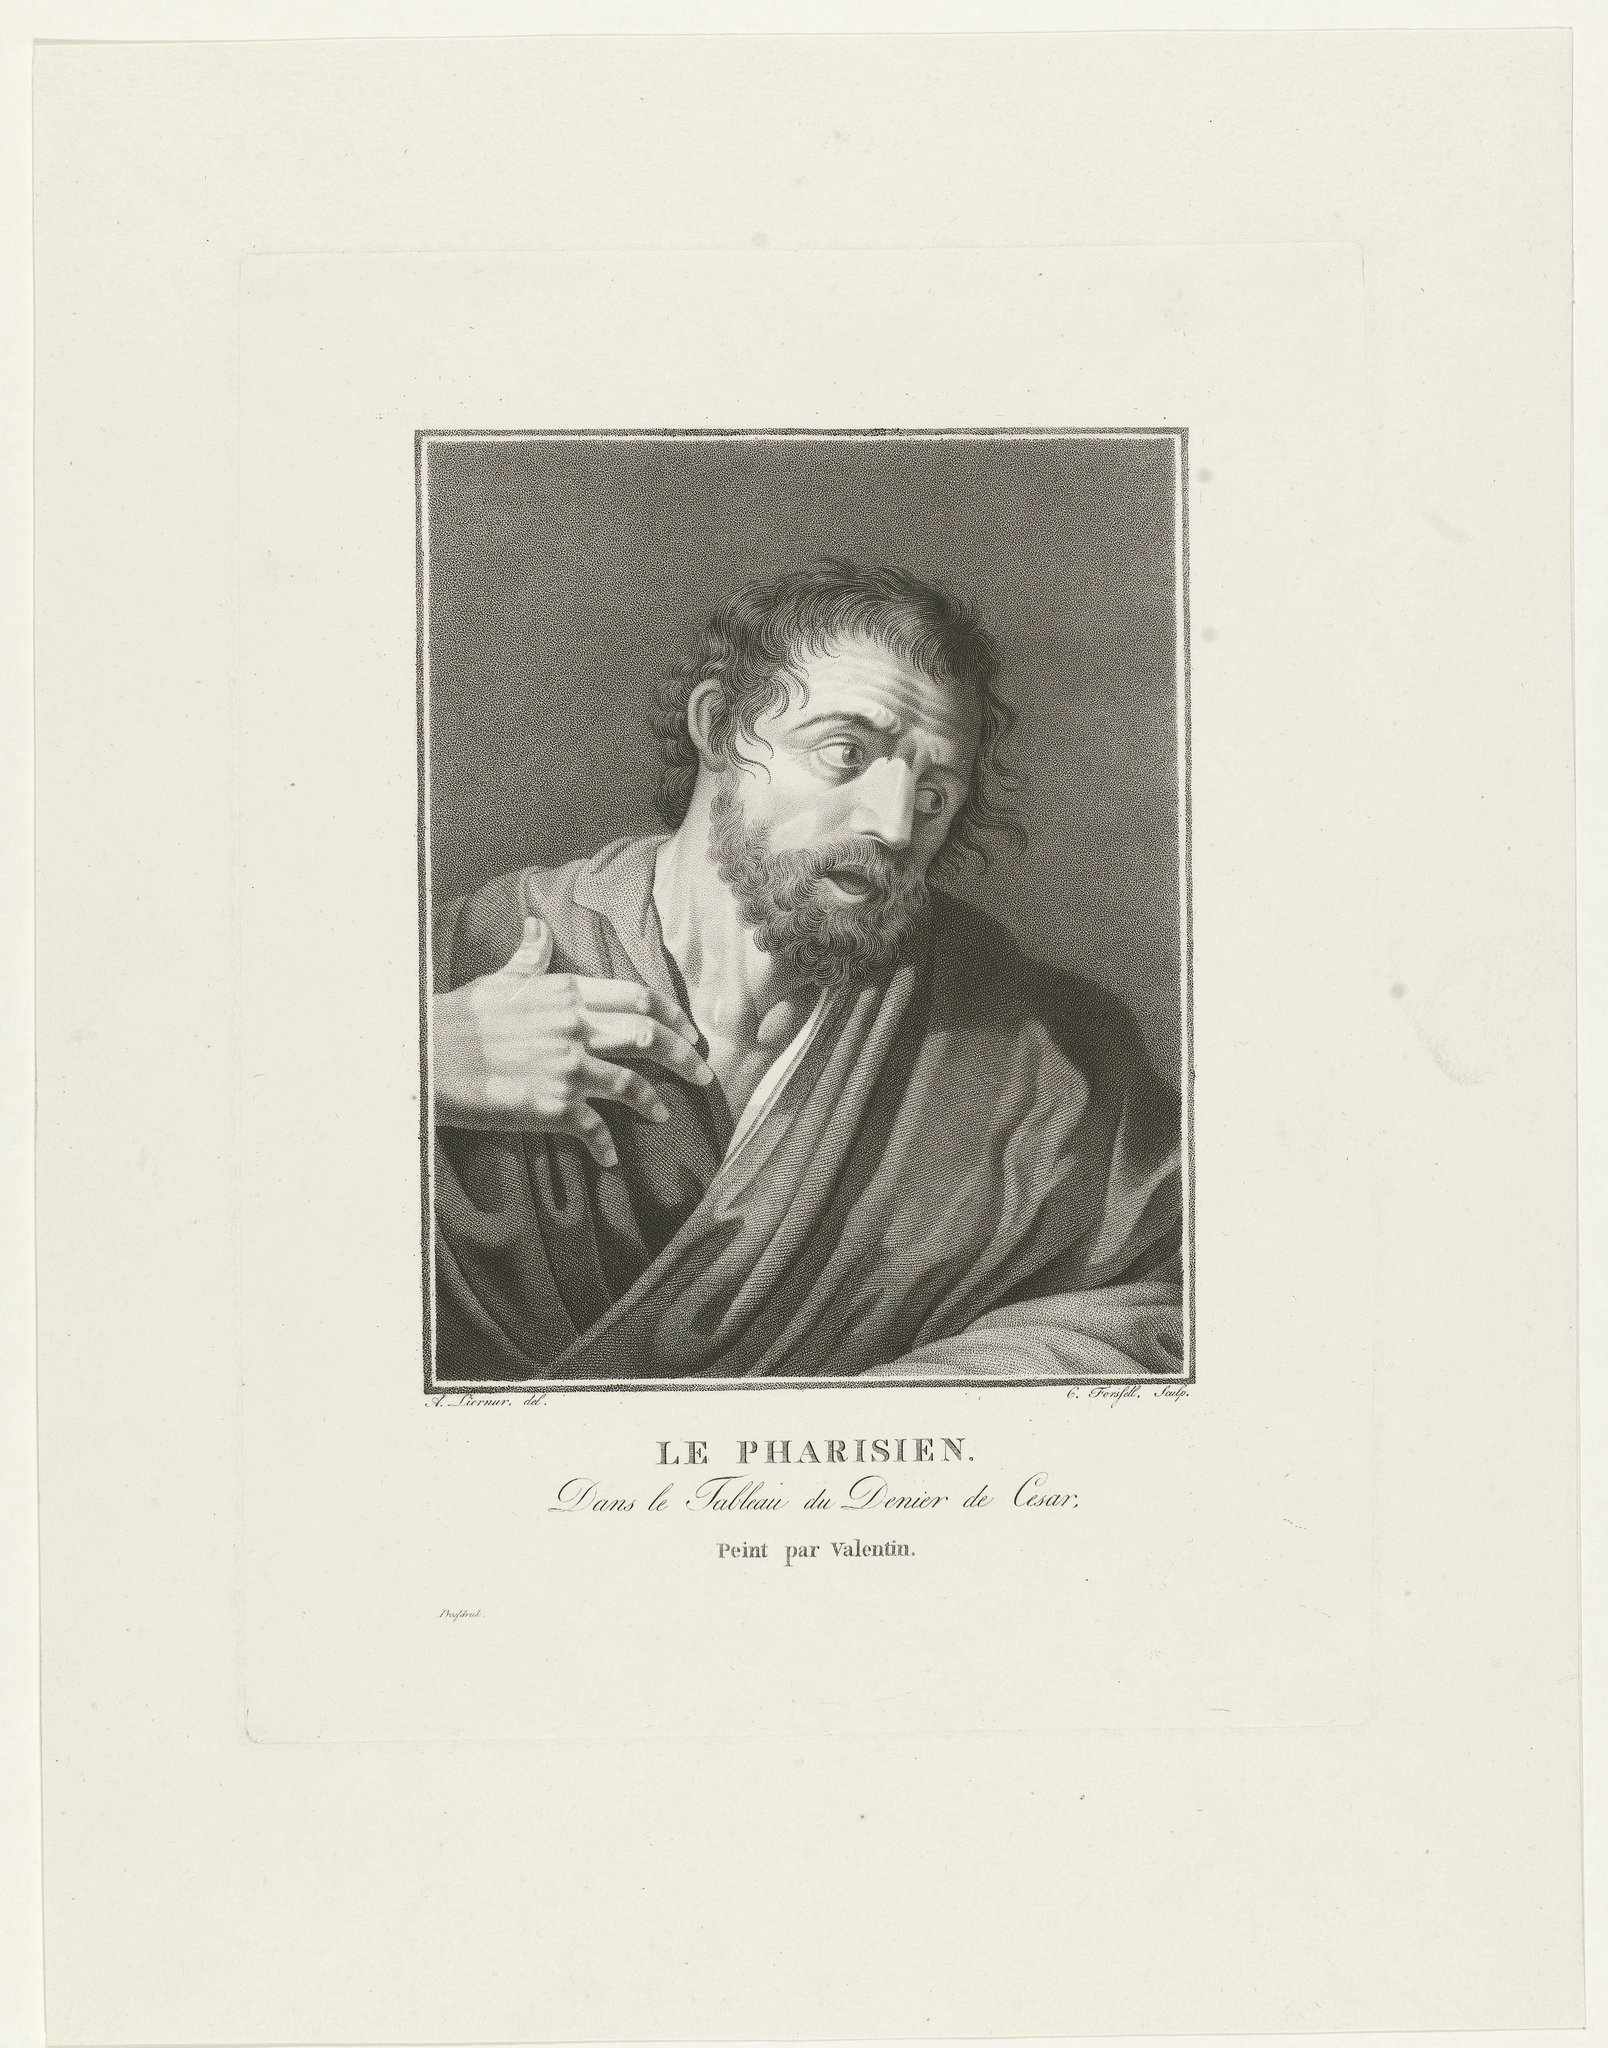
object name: print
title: Farizeeër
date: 1787-1852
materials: paper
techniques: engraving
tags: jewish sects, divisions, spiritual currents (pharisees)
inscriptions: collector's mark: Lugt 2228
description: Buste van een farizeeër, frontaal. Het hoofd is naar rechts gedraaid. In de marge staan twee regels tekst in het Frans.